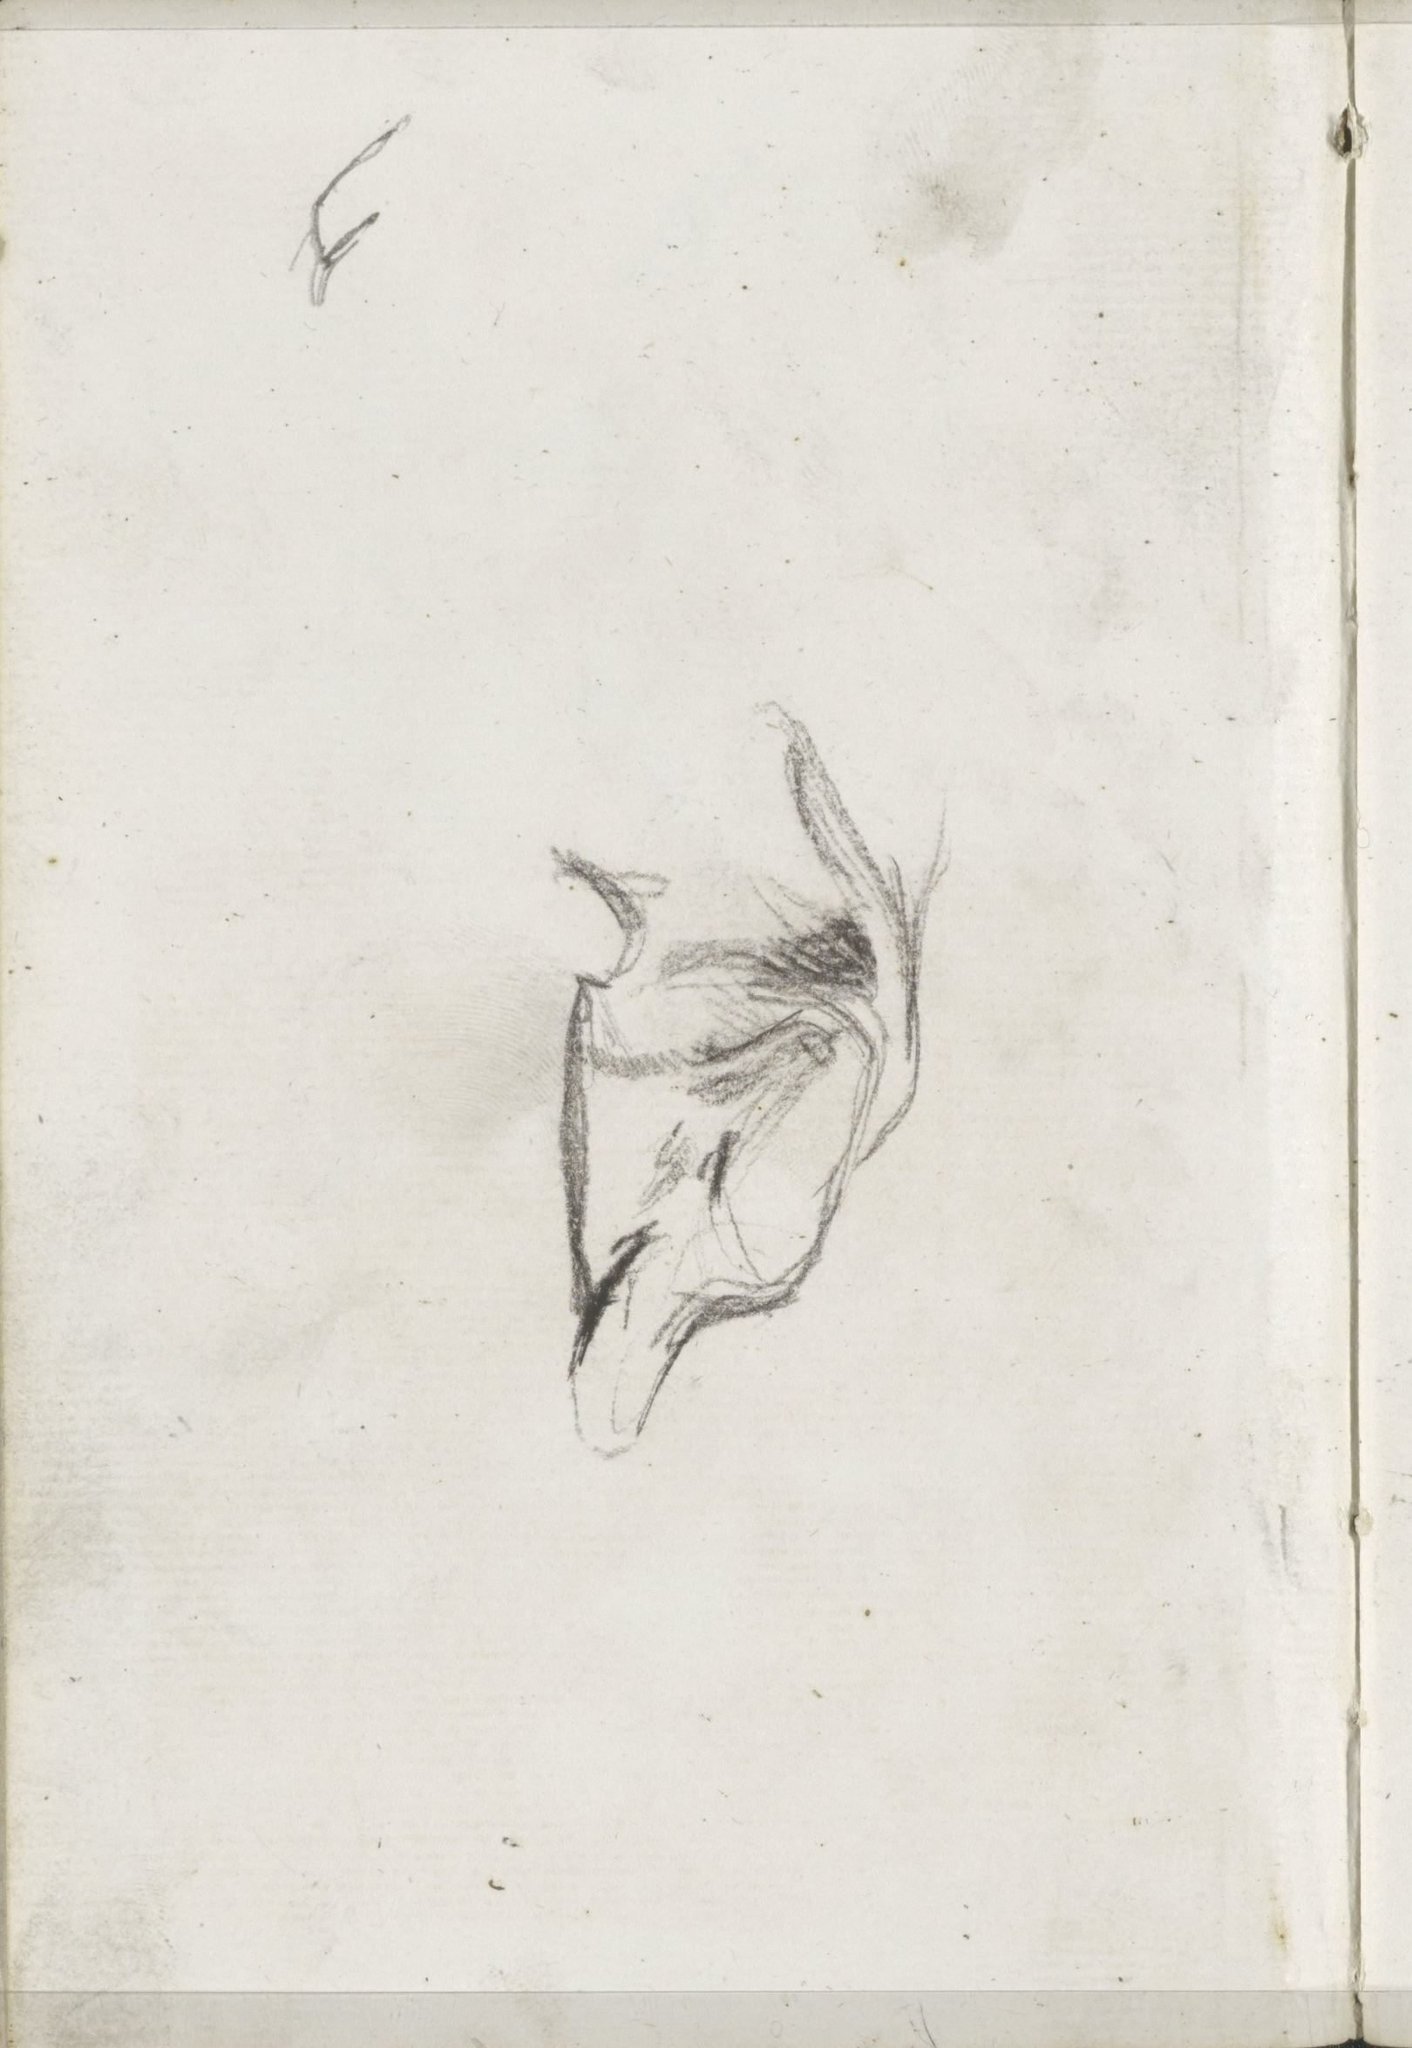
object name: sketchbook leaf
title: Kop van een kat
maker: george hendrik breitner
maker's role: draughtsman, painter, print maker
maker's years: 1857-1923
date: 1886-1895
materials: chalk, paper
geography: amsterdam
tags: cat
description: Pagina 5 uit een schetsboek met 20 bladen.